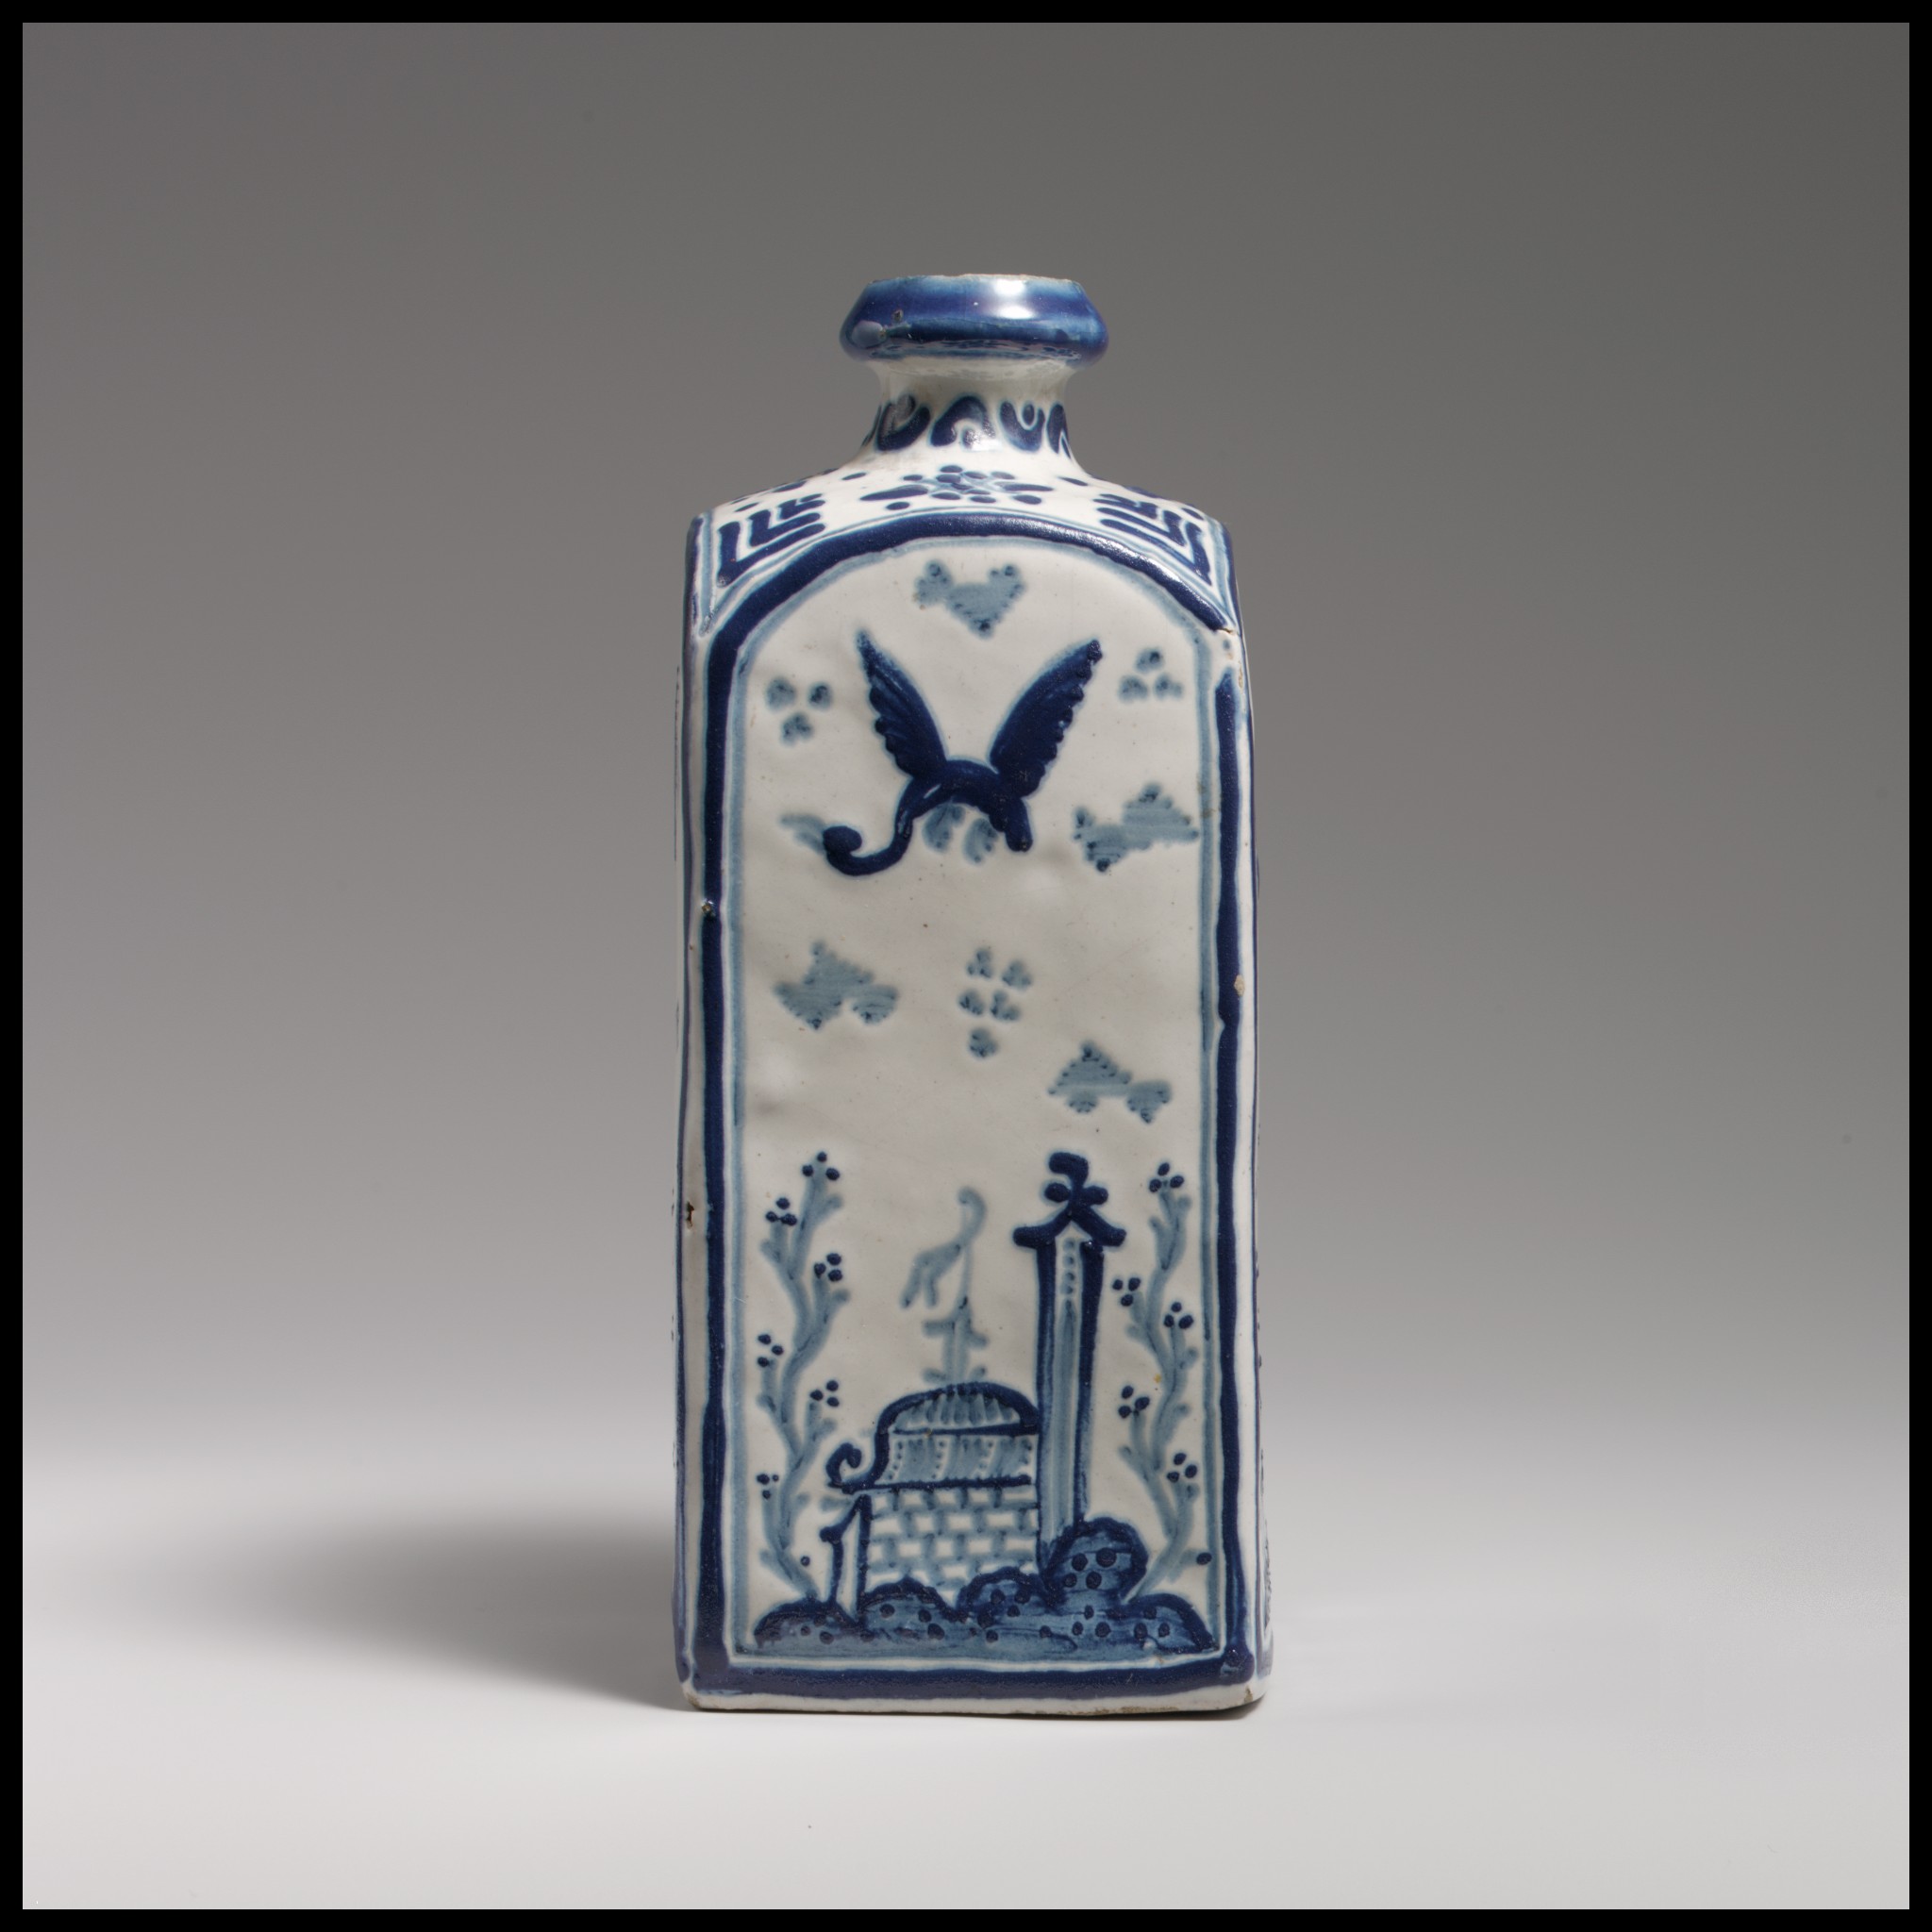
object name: bottle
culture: mexican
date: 1800-1900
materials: earthenware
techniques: glazing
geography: mexico